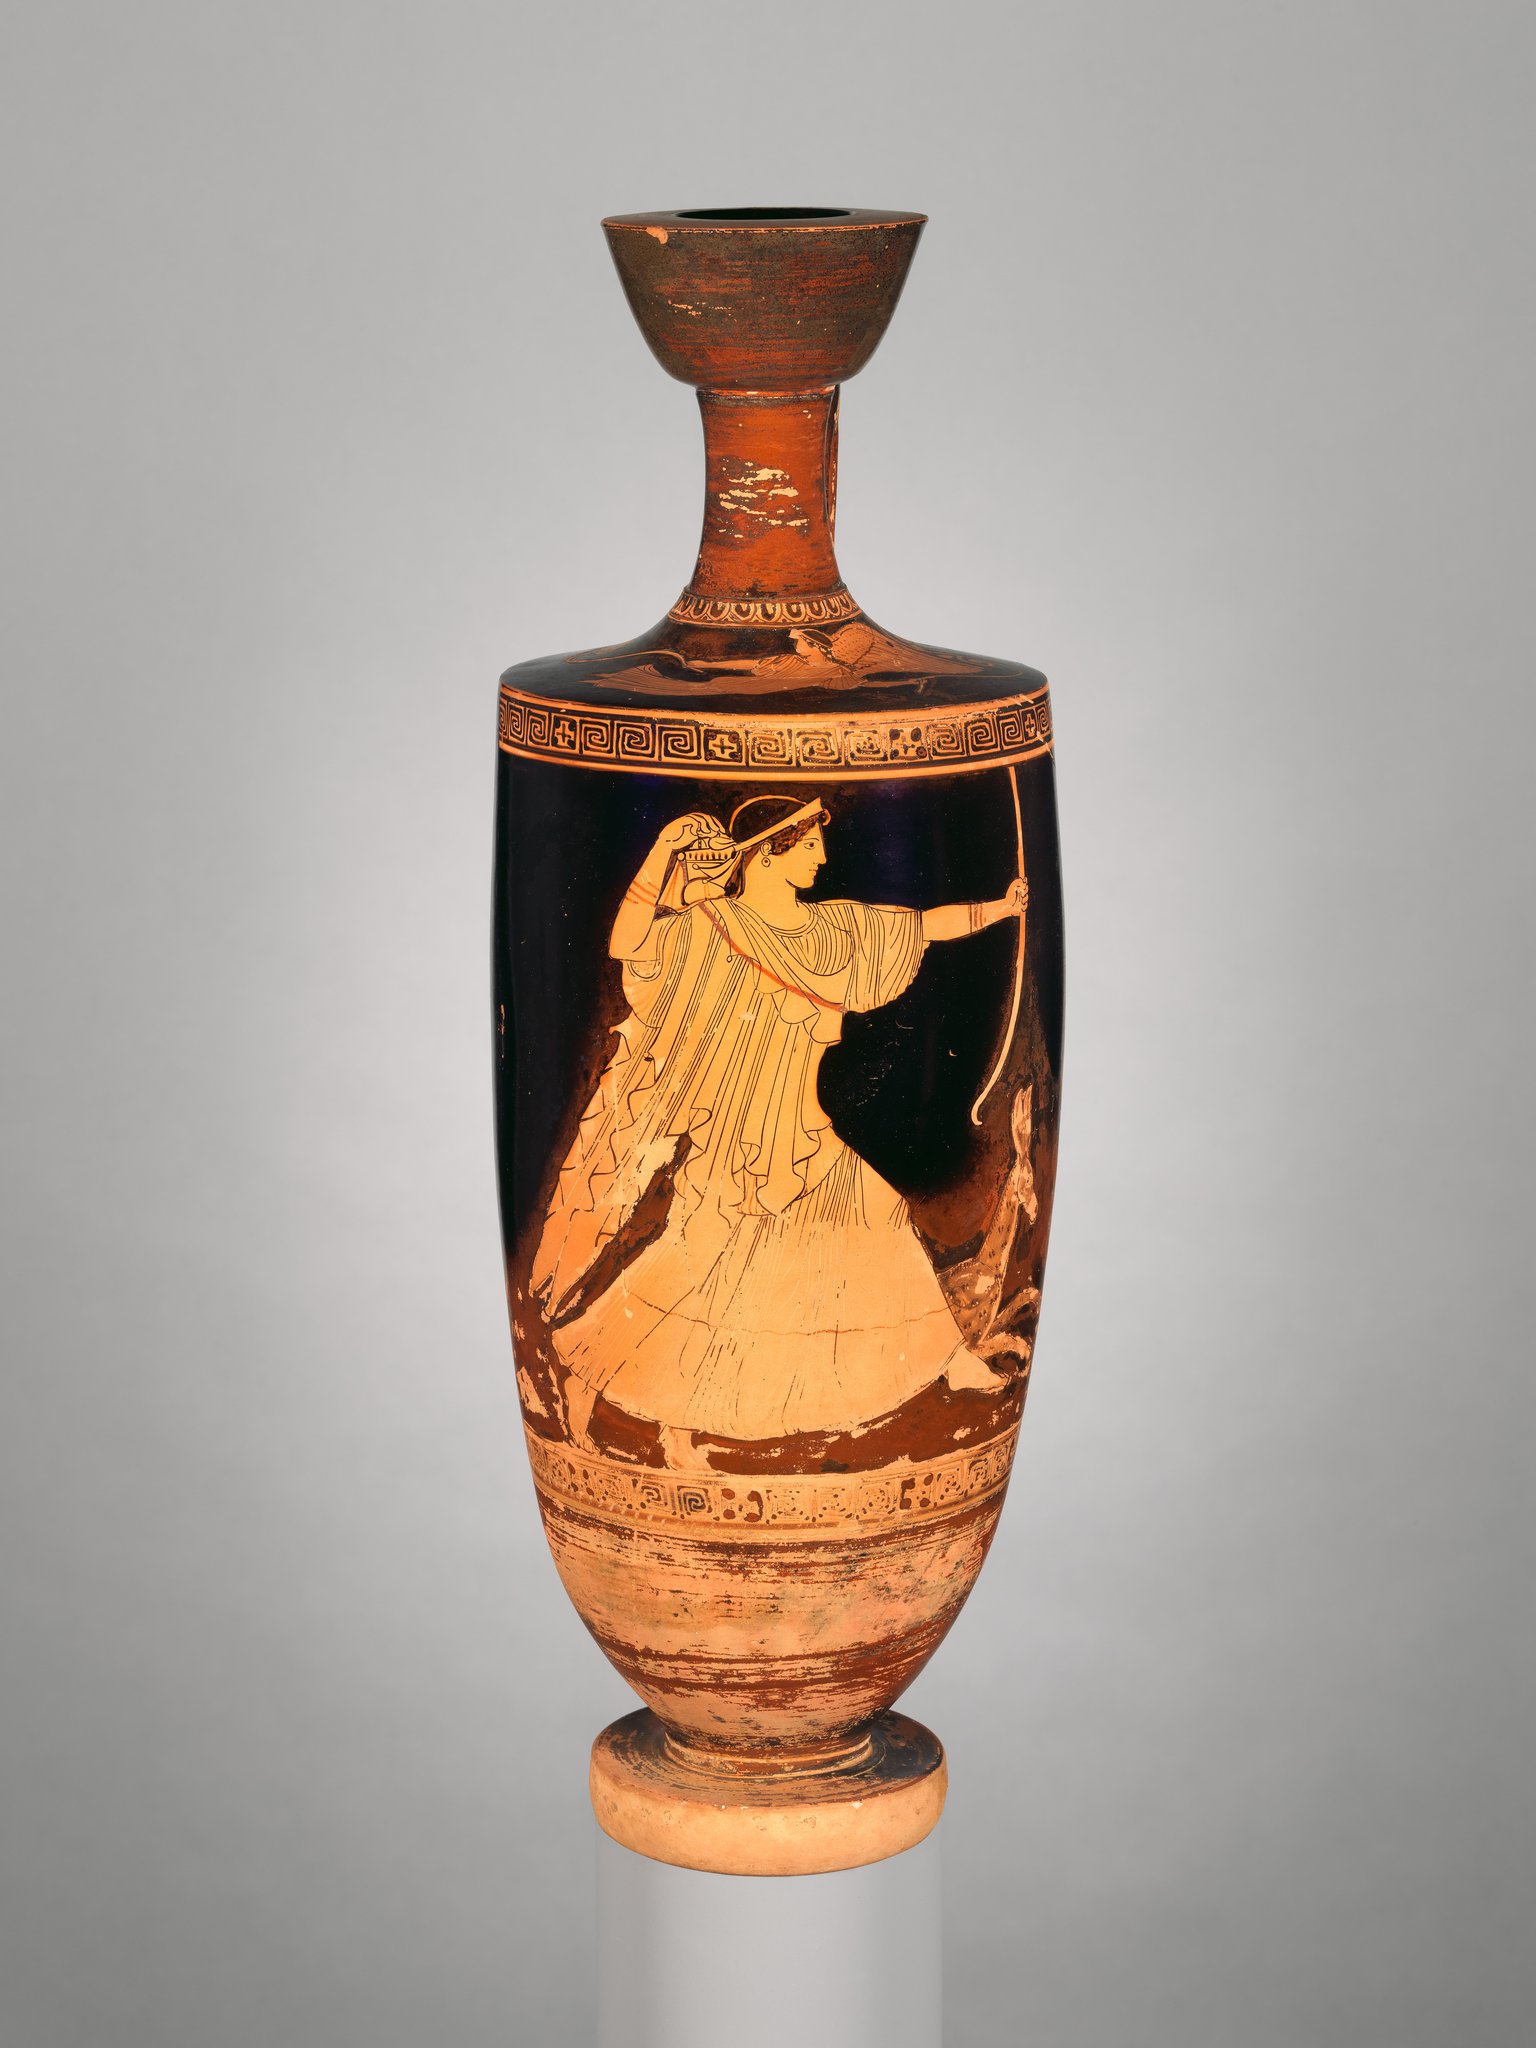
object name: lekythos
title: Terracotta lekythos (oil flask)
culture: greek, attic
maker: providence painter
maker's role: artist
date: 480 BCE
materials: terracotta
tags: bow and arrow,artemis,nike